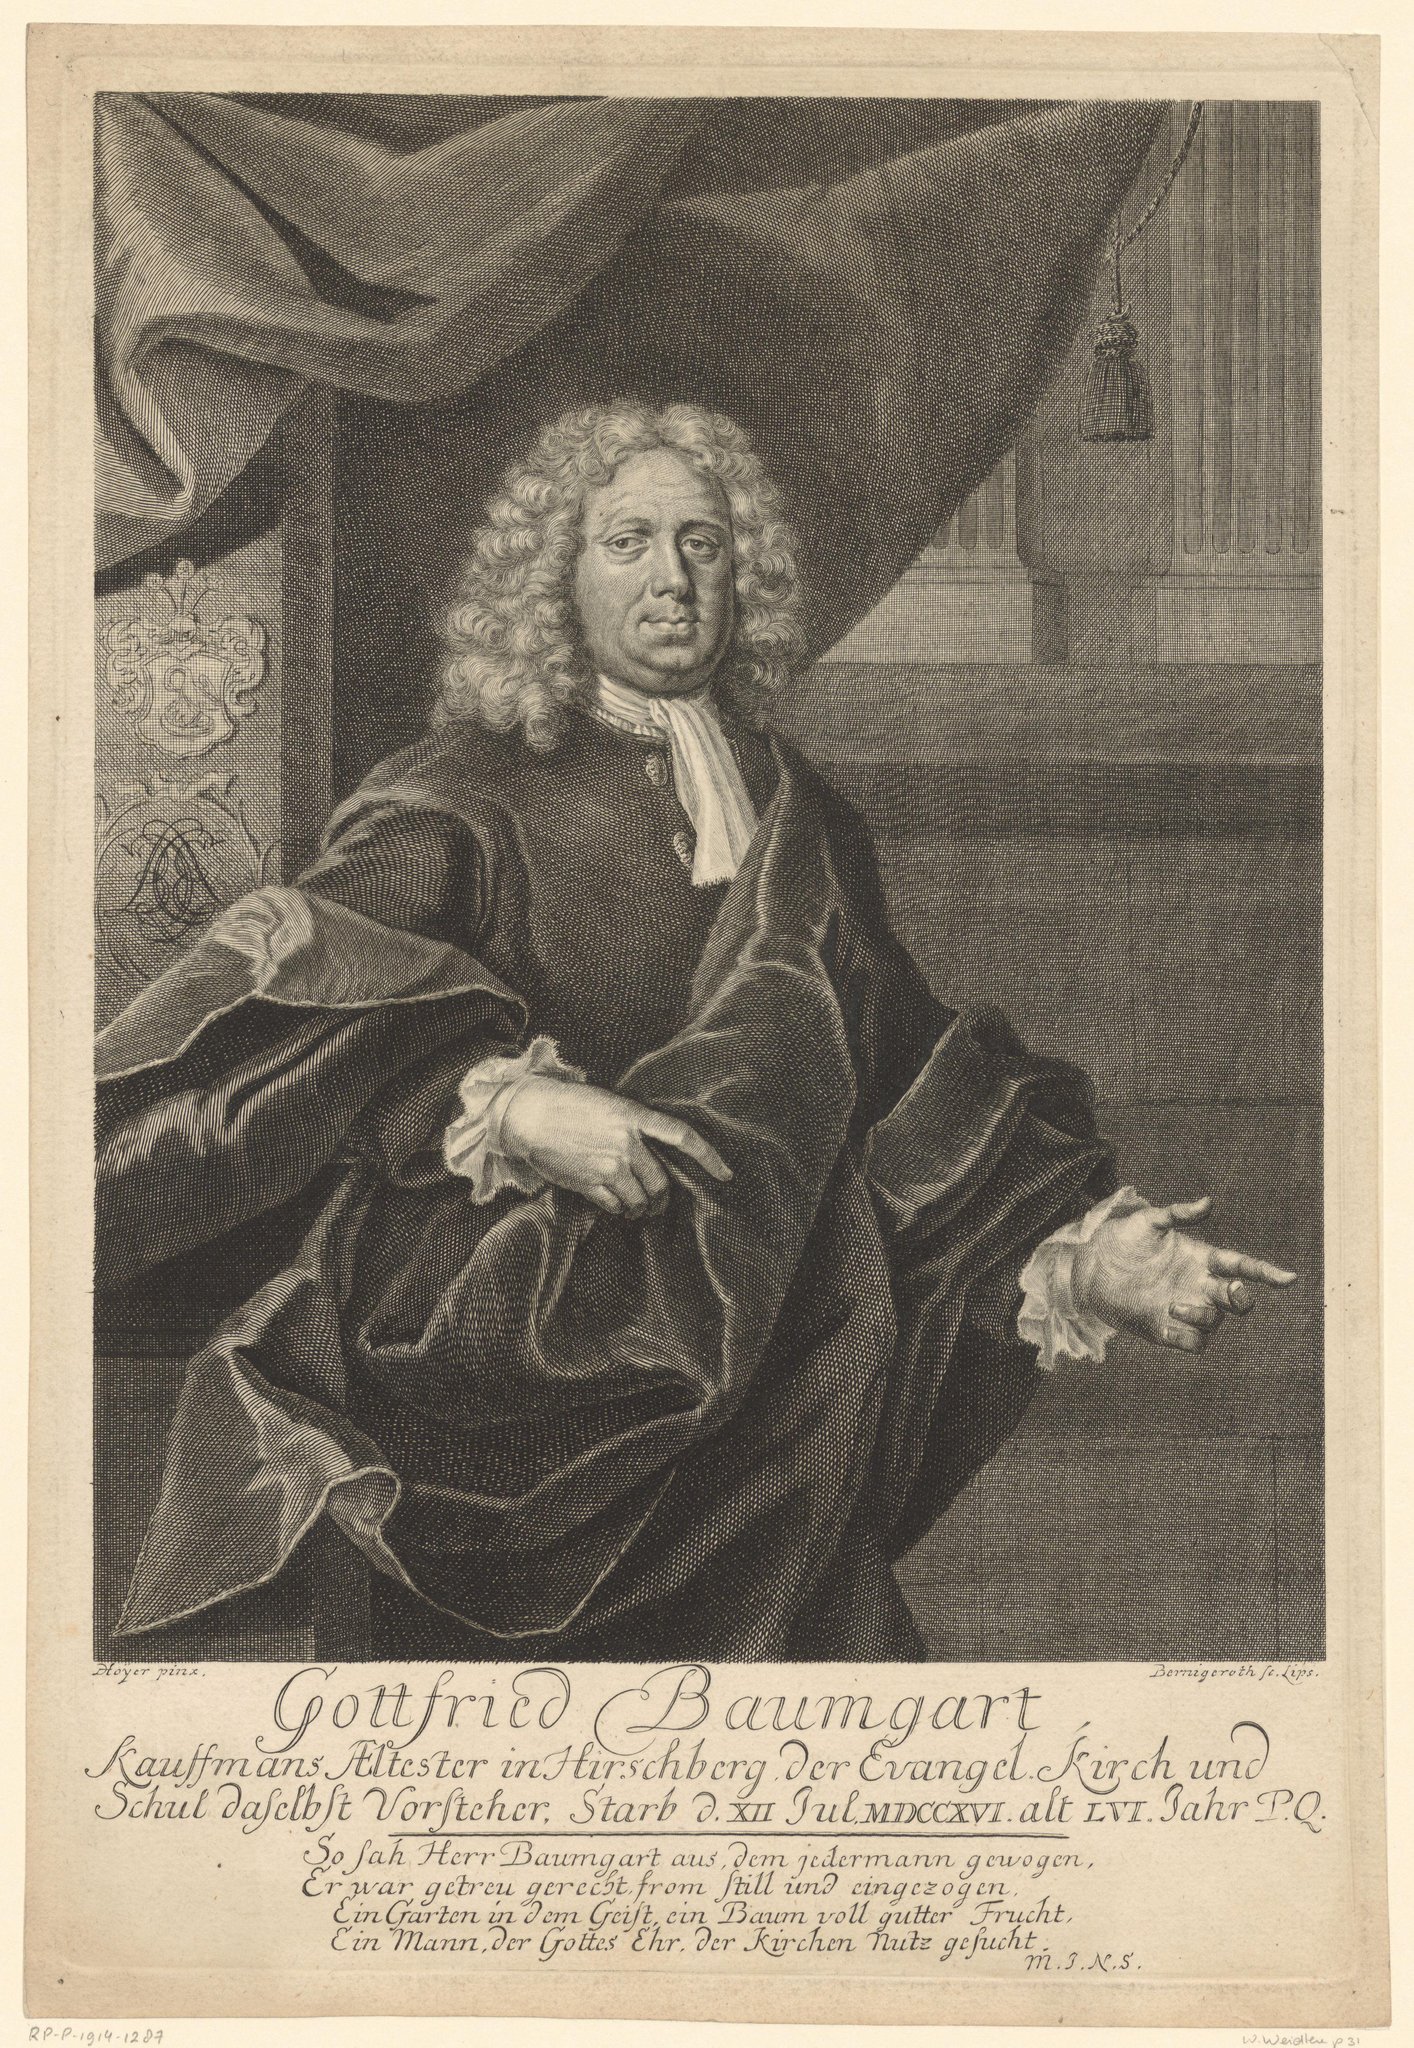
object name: print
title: Portret van Gottfried Baumgart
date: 1716-1733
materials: paper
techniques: engraving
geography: leipzig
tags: historical persons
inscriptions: collector's mark: Lugt 2228